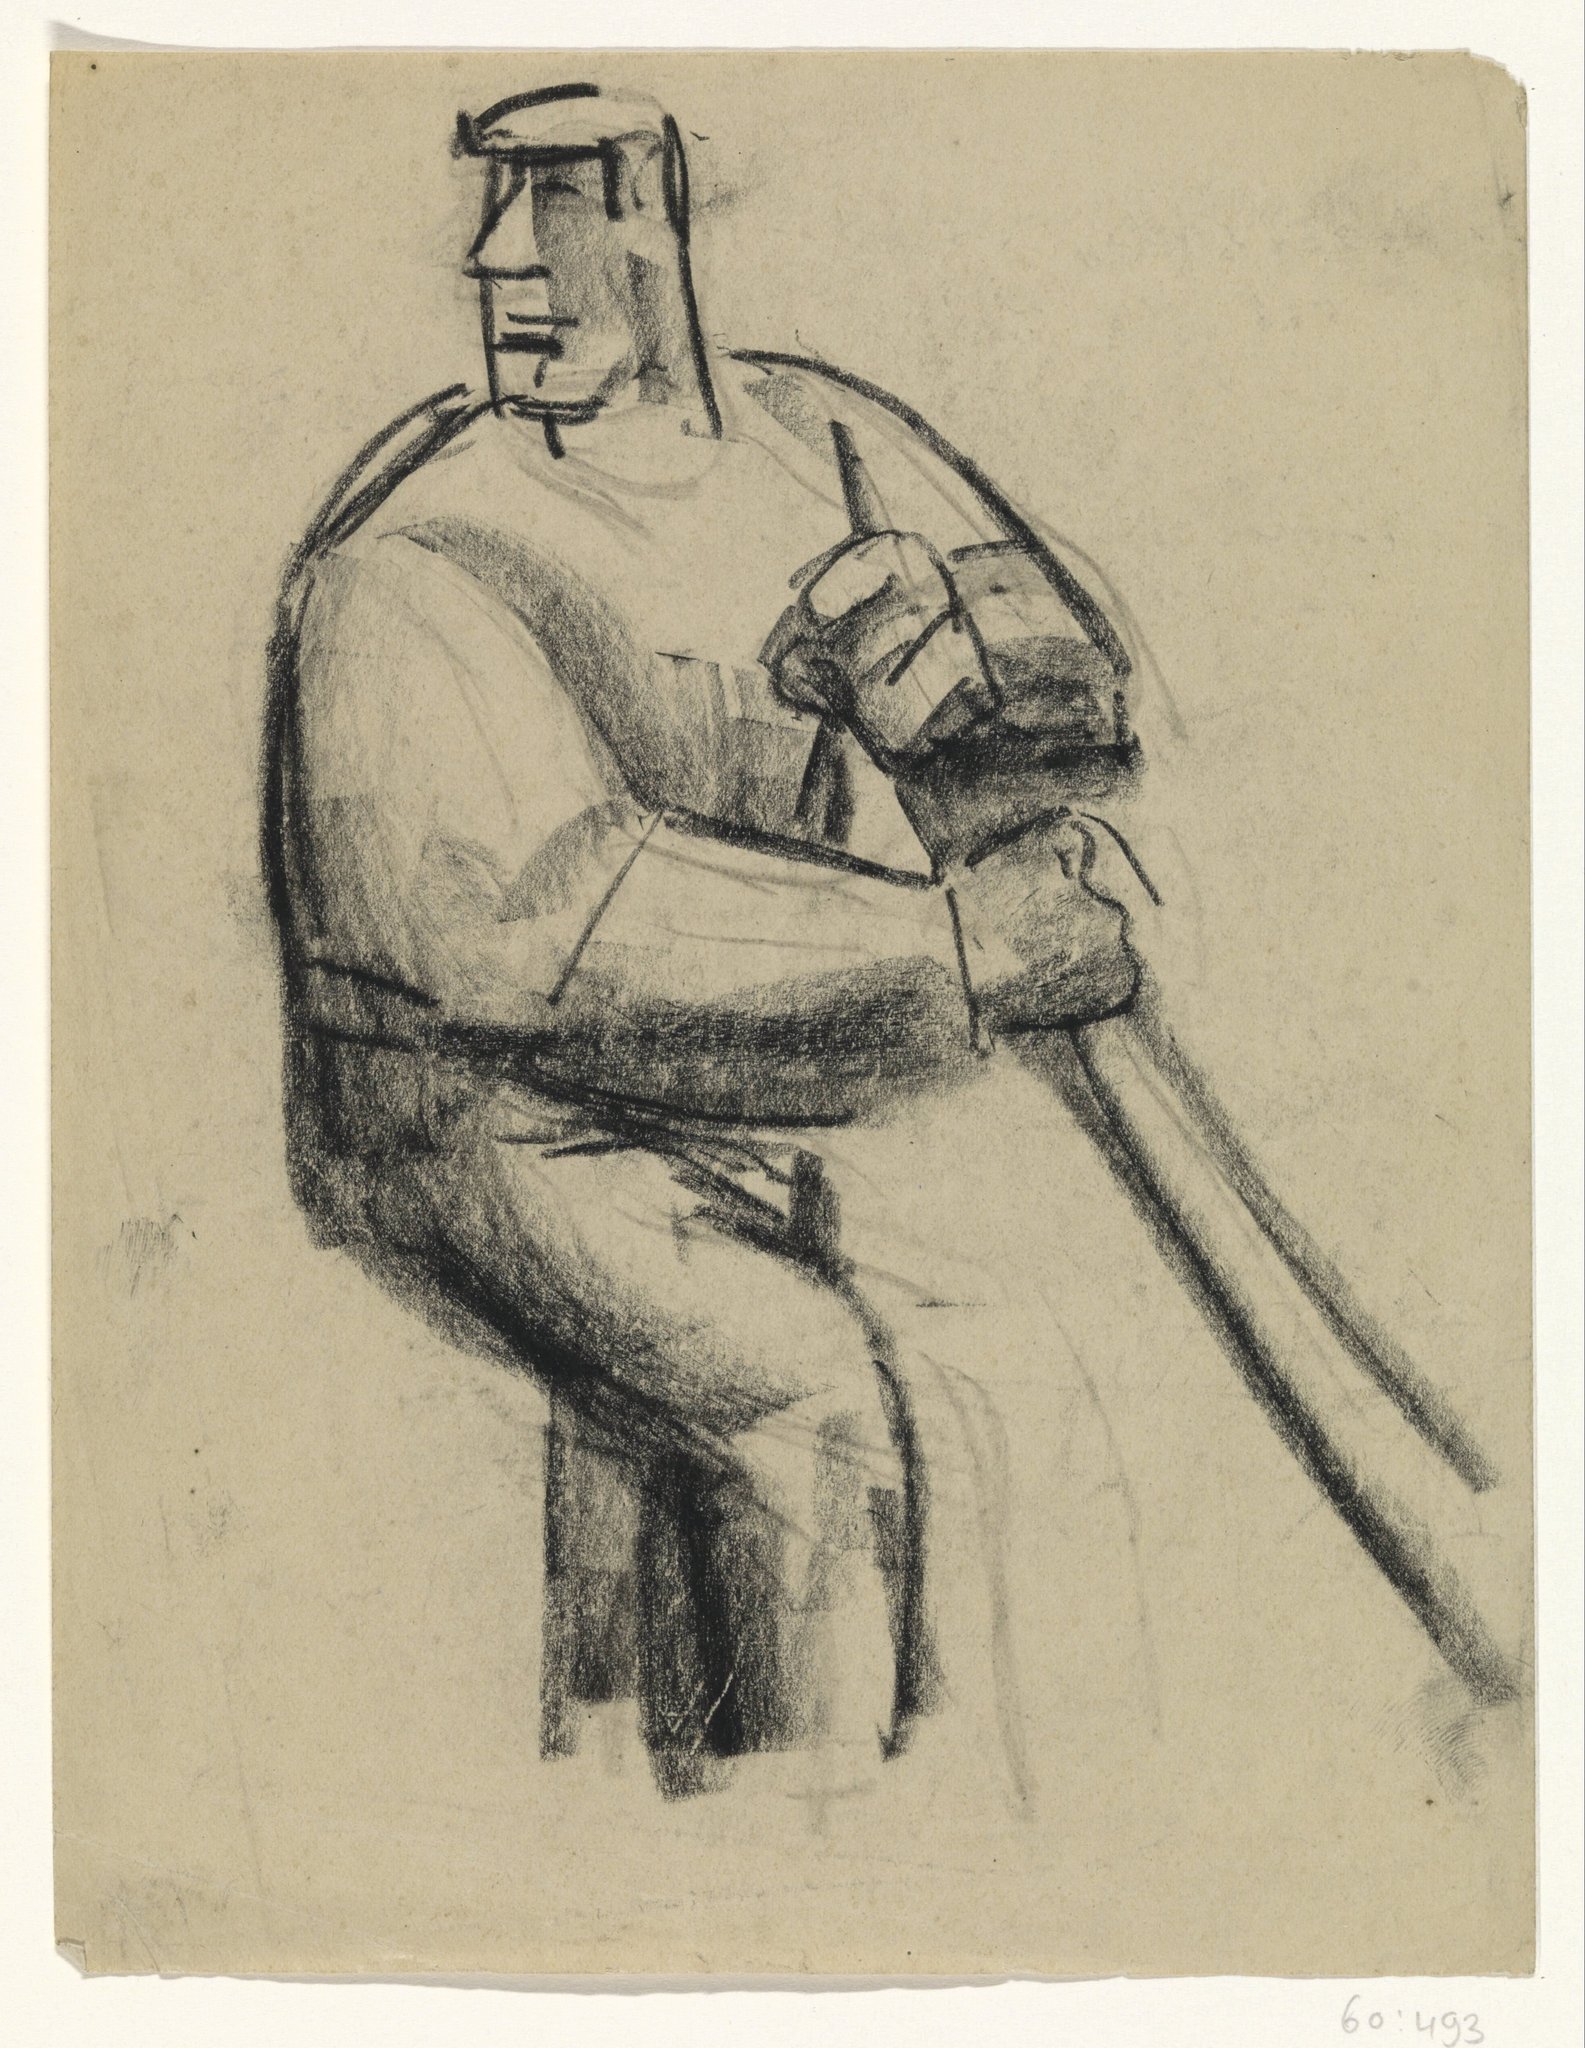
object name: drawing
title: Man met stok in de hand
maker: leo gestel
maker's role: draughtsman, print maker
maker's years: 1881-1941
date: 1891-1941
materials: chalk, paper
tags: standing figure, adult man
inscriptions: collector's mark: Lugt 2228